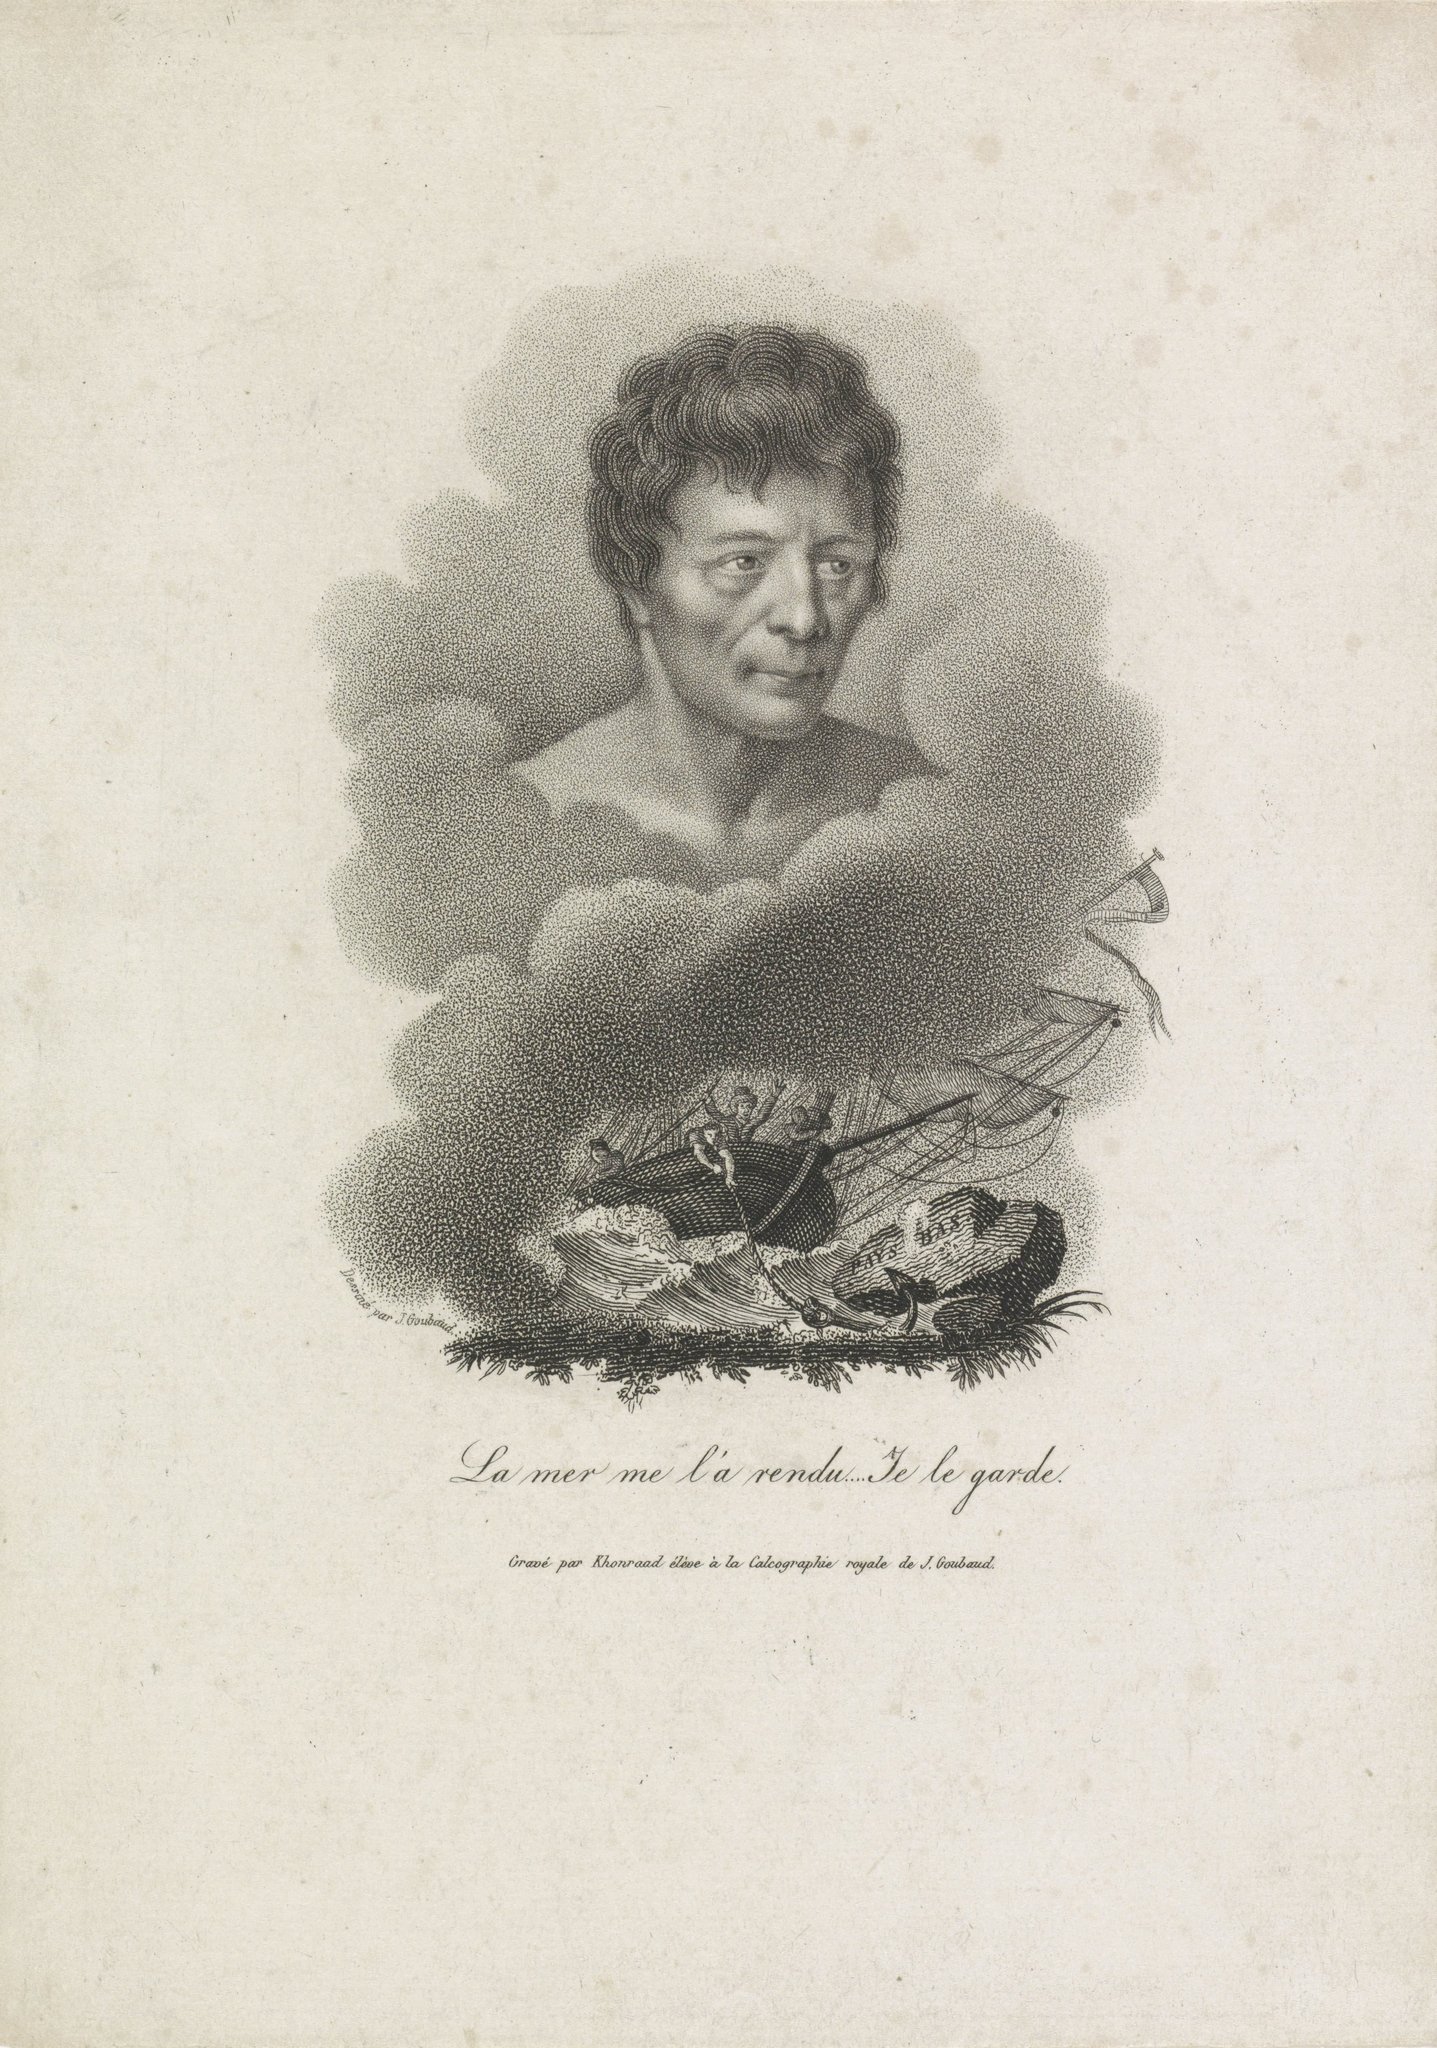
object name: print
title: La mer me l'a rendu (...) Je le garde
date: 1820-1829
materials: paper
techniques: engraving, etching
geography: southern netherlands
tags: shipwreck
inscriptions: collector's mark: Lugt 2228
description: Borstbeeld van de Franse uitgewekene Merlin door wolken omgeven, daaronder zijn schipbreuk aan de Nederlandse kust in 1829. Op Franse verzoeken om uitlevering van Merlin antwoorde koning Willem I met de woorden 'La mer me l'a rendu ... Je le garde'.